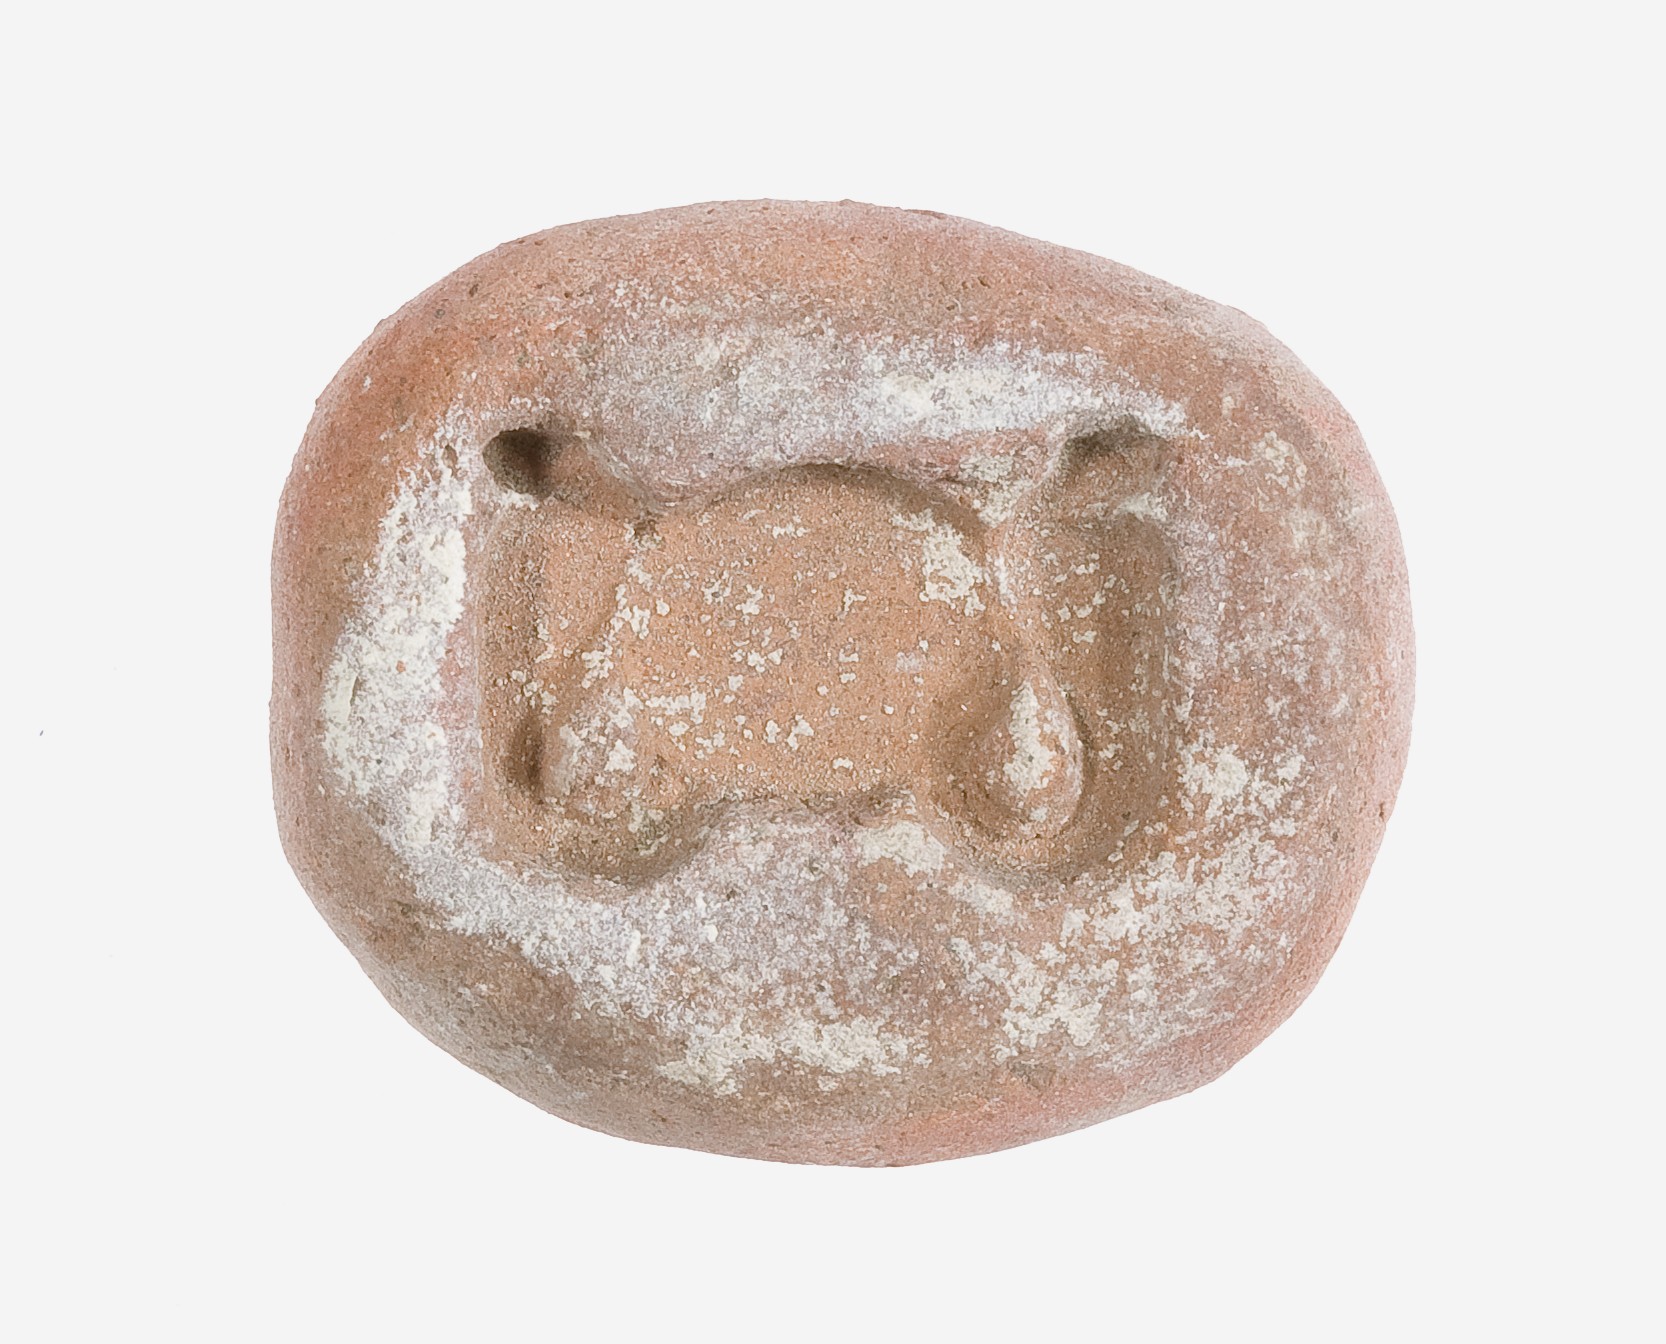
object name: mold, amulet, sun disk and uraeus cobra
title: Mold for a Sun Disk Flanked by Uraeus Cobras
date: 1390-1352 BCE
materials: pottery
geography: egypt